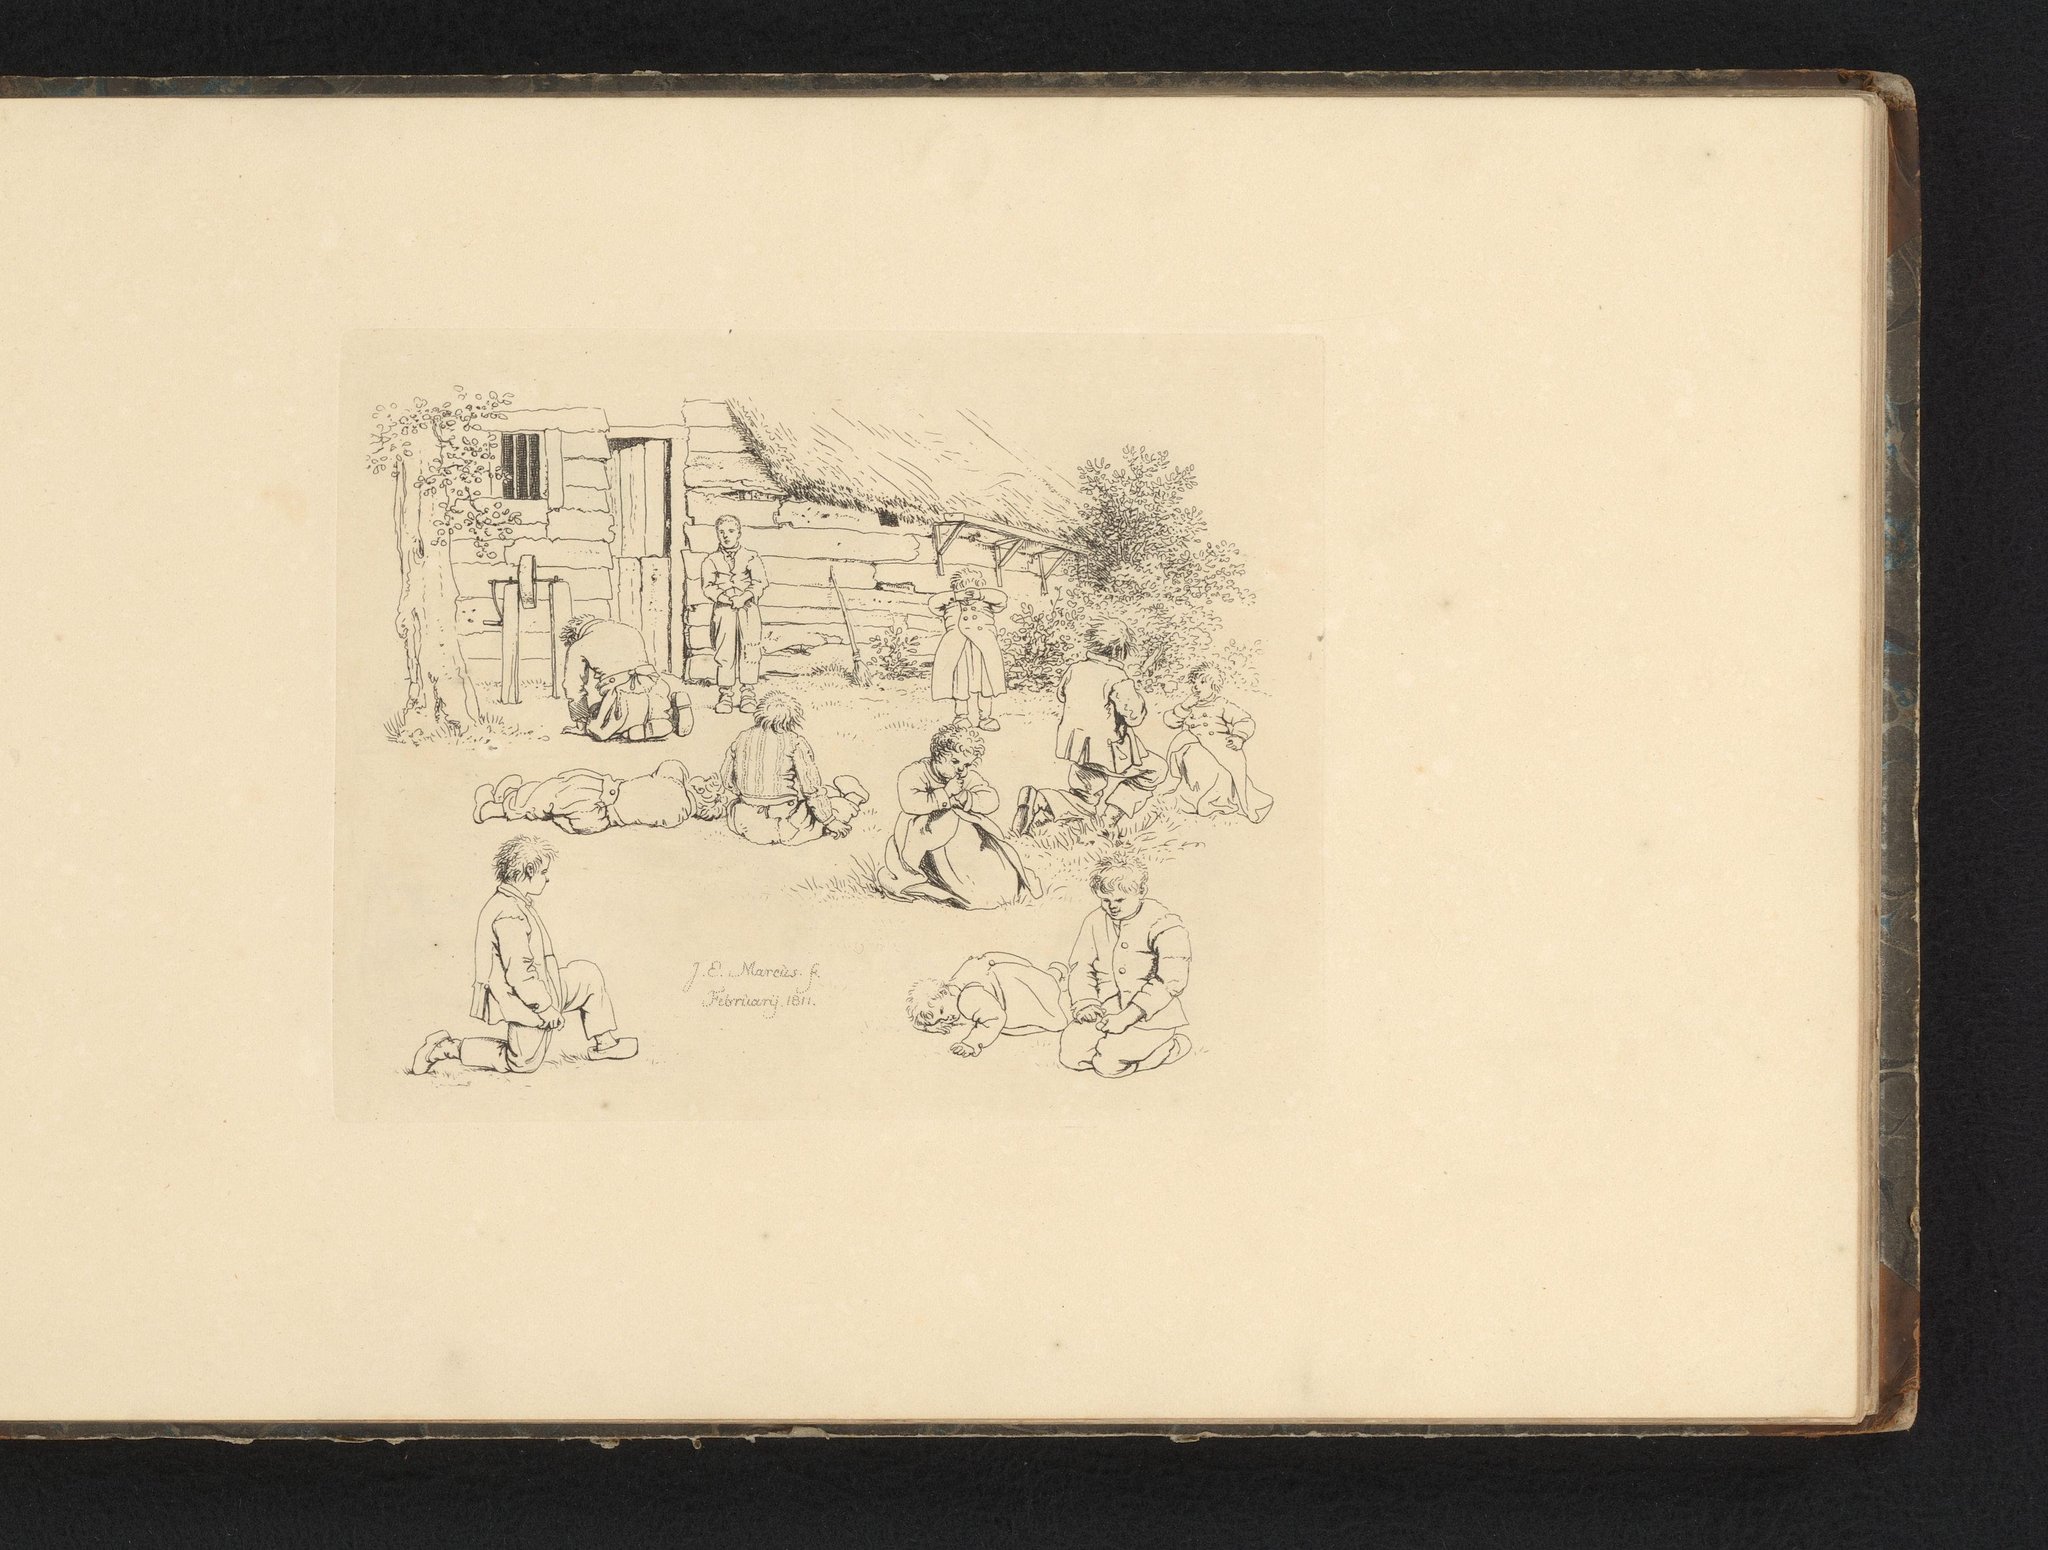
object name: print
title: Groep kinderen buiten een dorpsschool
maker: jacob ernst marcus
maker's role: draughtsman, print maker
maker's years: 1774-1826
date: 1802-1811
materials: paper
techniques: etching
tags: games at school, teacher and pupil, elementary school; class, form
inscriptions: date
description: Deze prent maakt deel uit van een album.